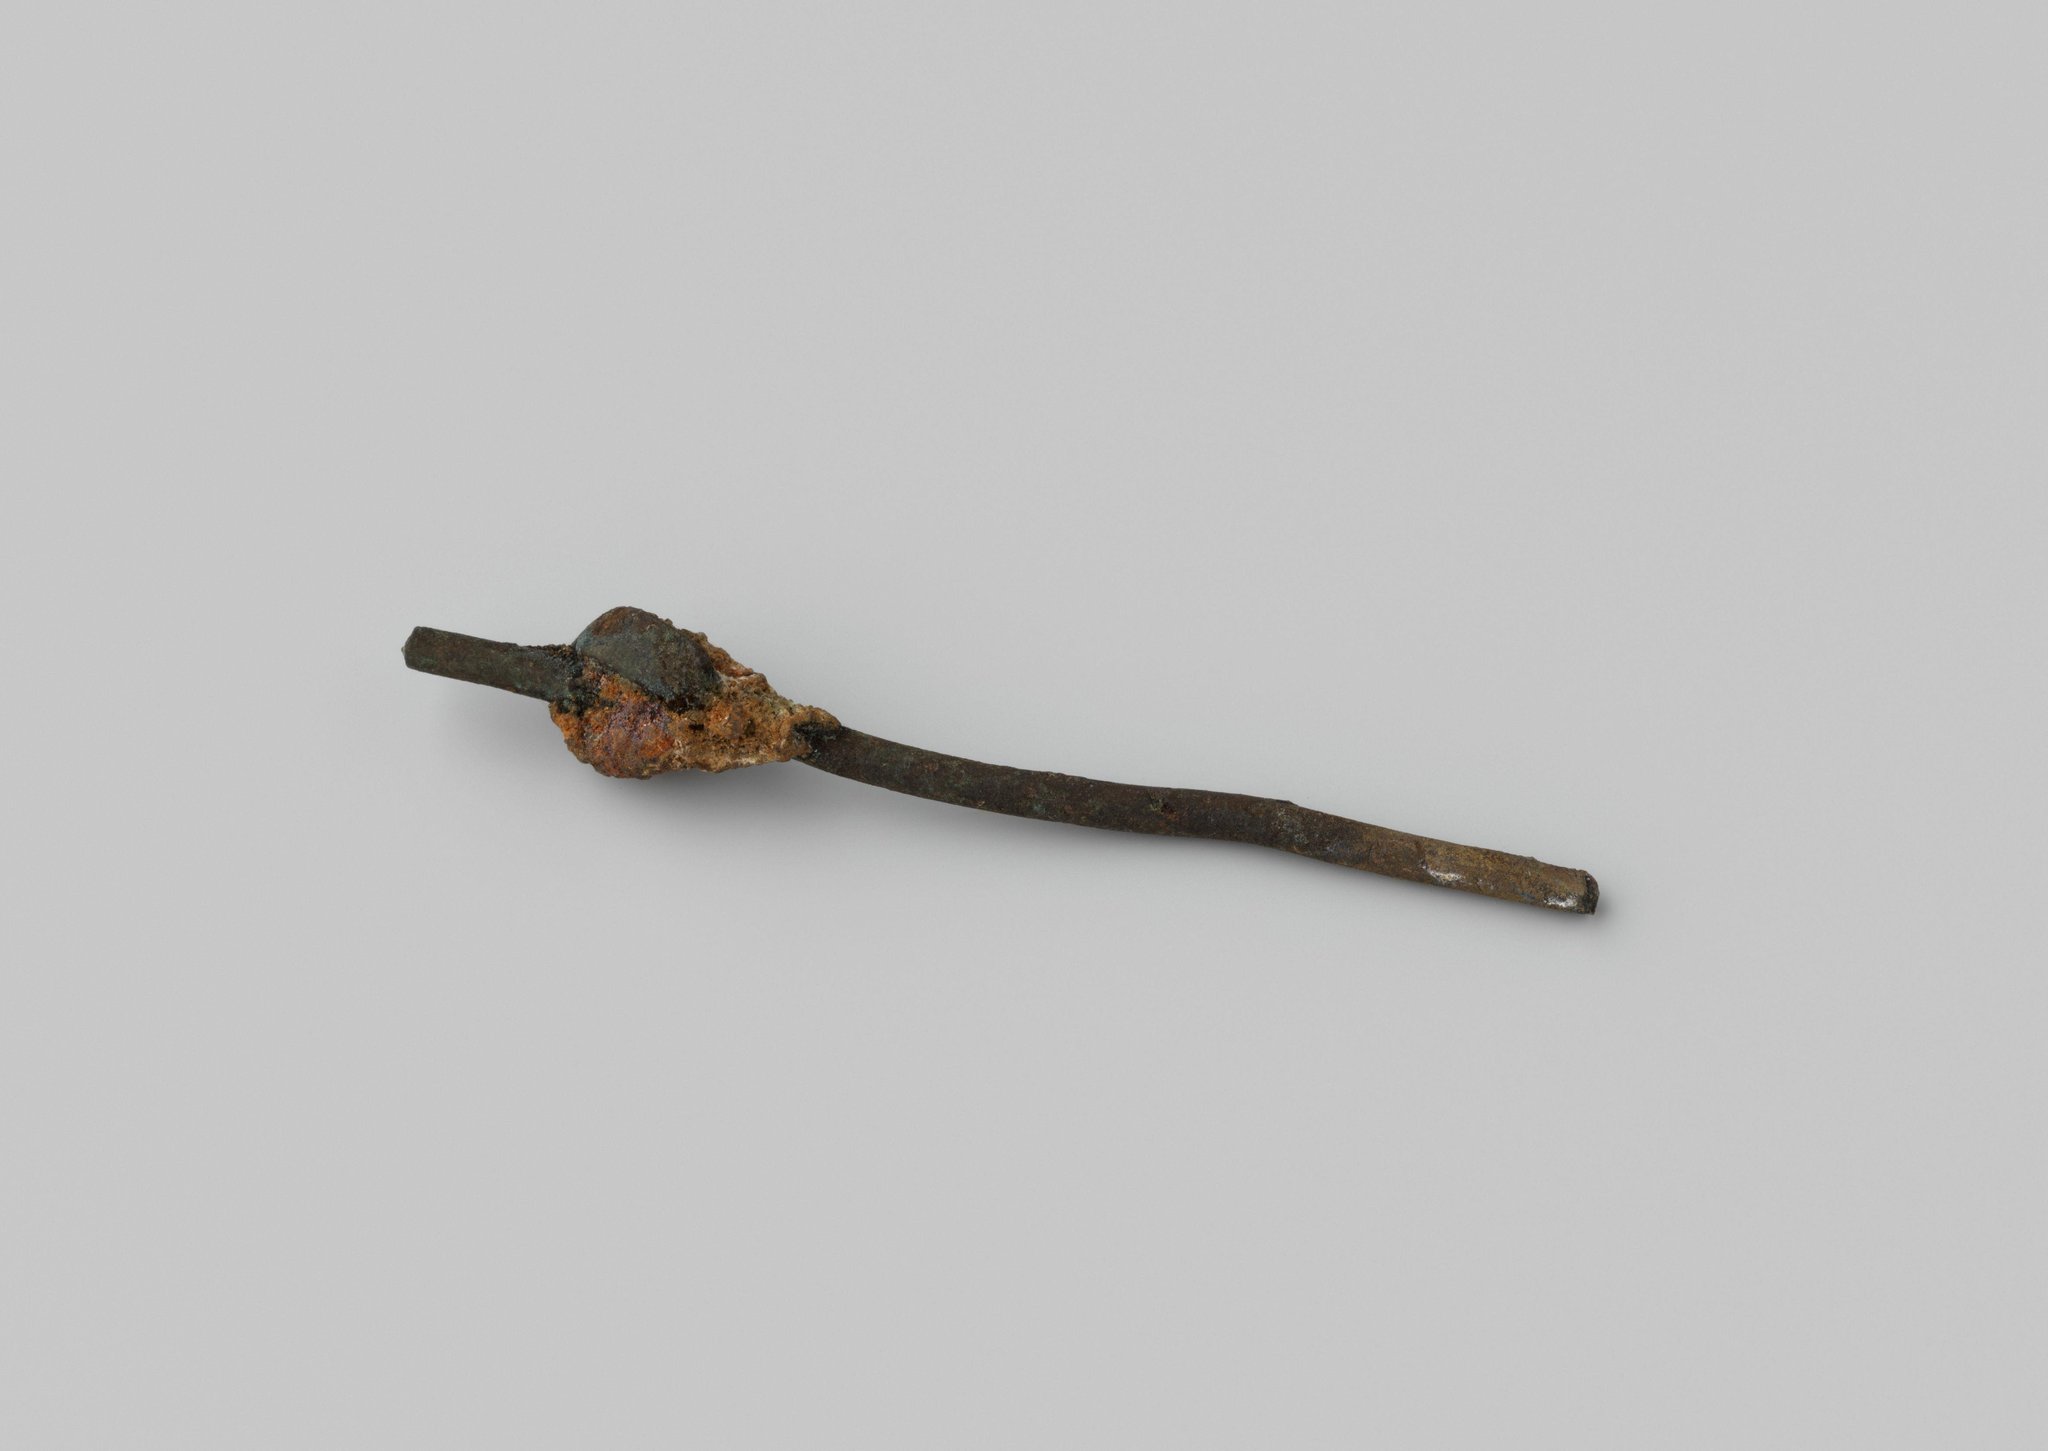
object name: fragment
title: Fragment of onderdeel uit het wrak van de Oost-Indiëvaarder Hollandia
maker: Anonymous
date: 1743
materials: copper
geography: netherlands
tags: verenigde oostindische compagnie, hollandia (schip), annet